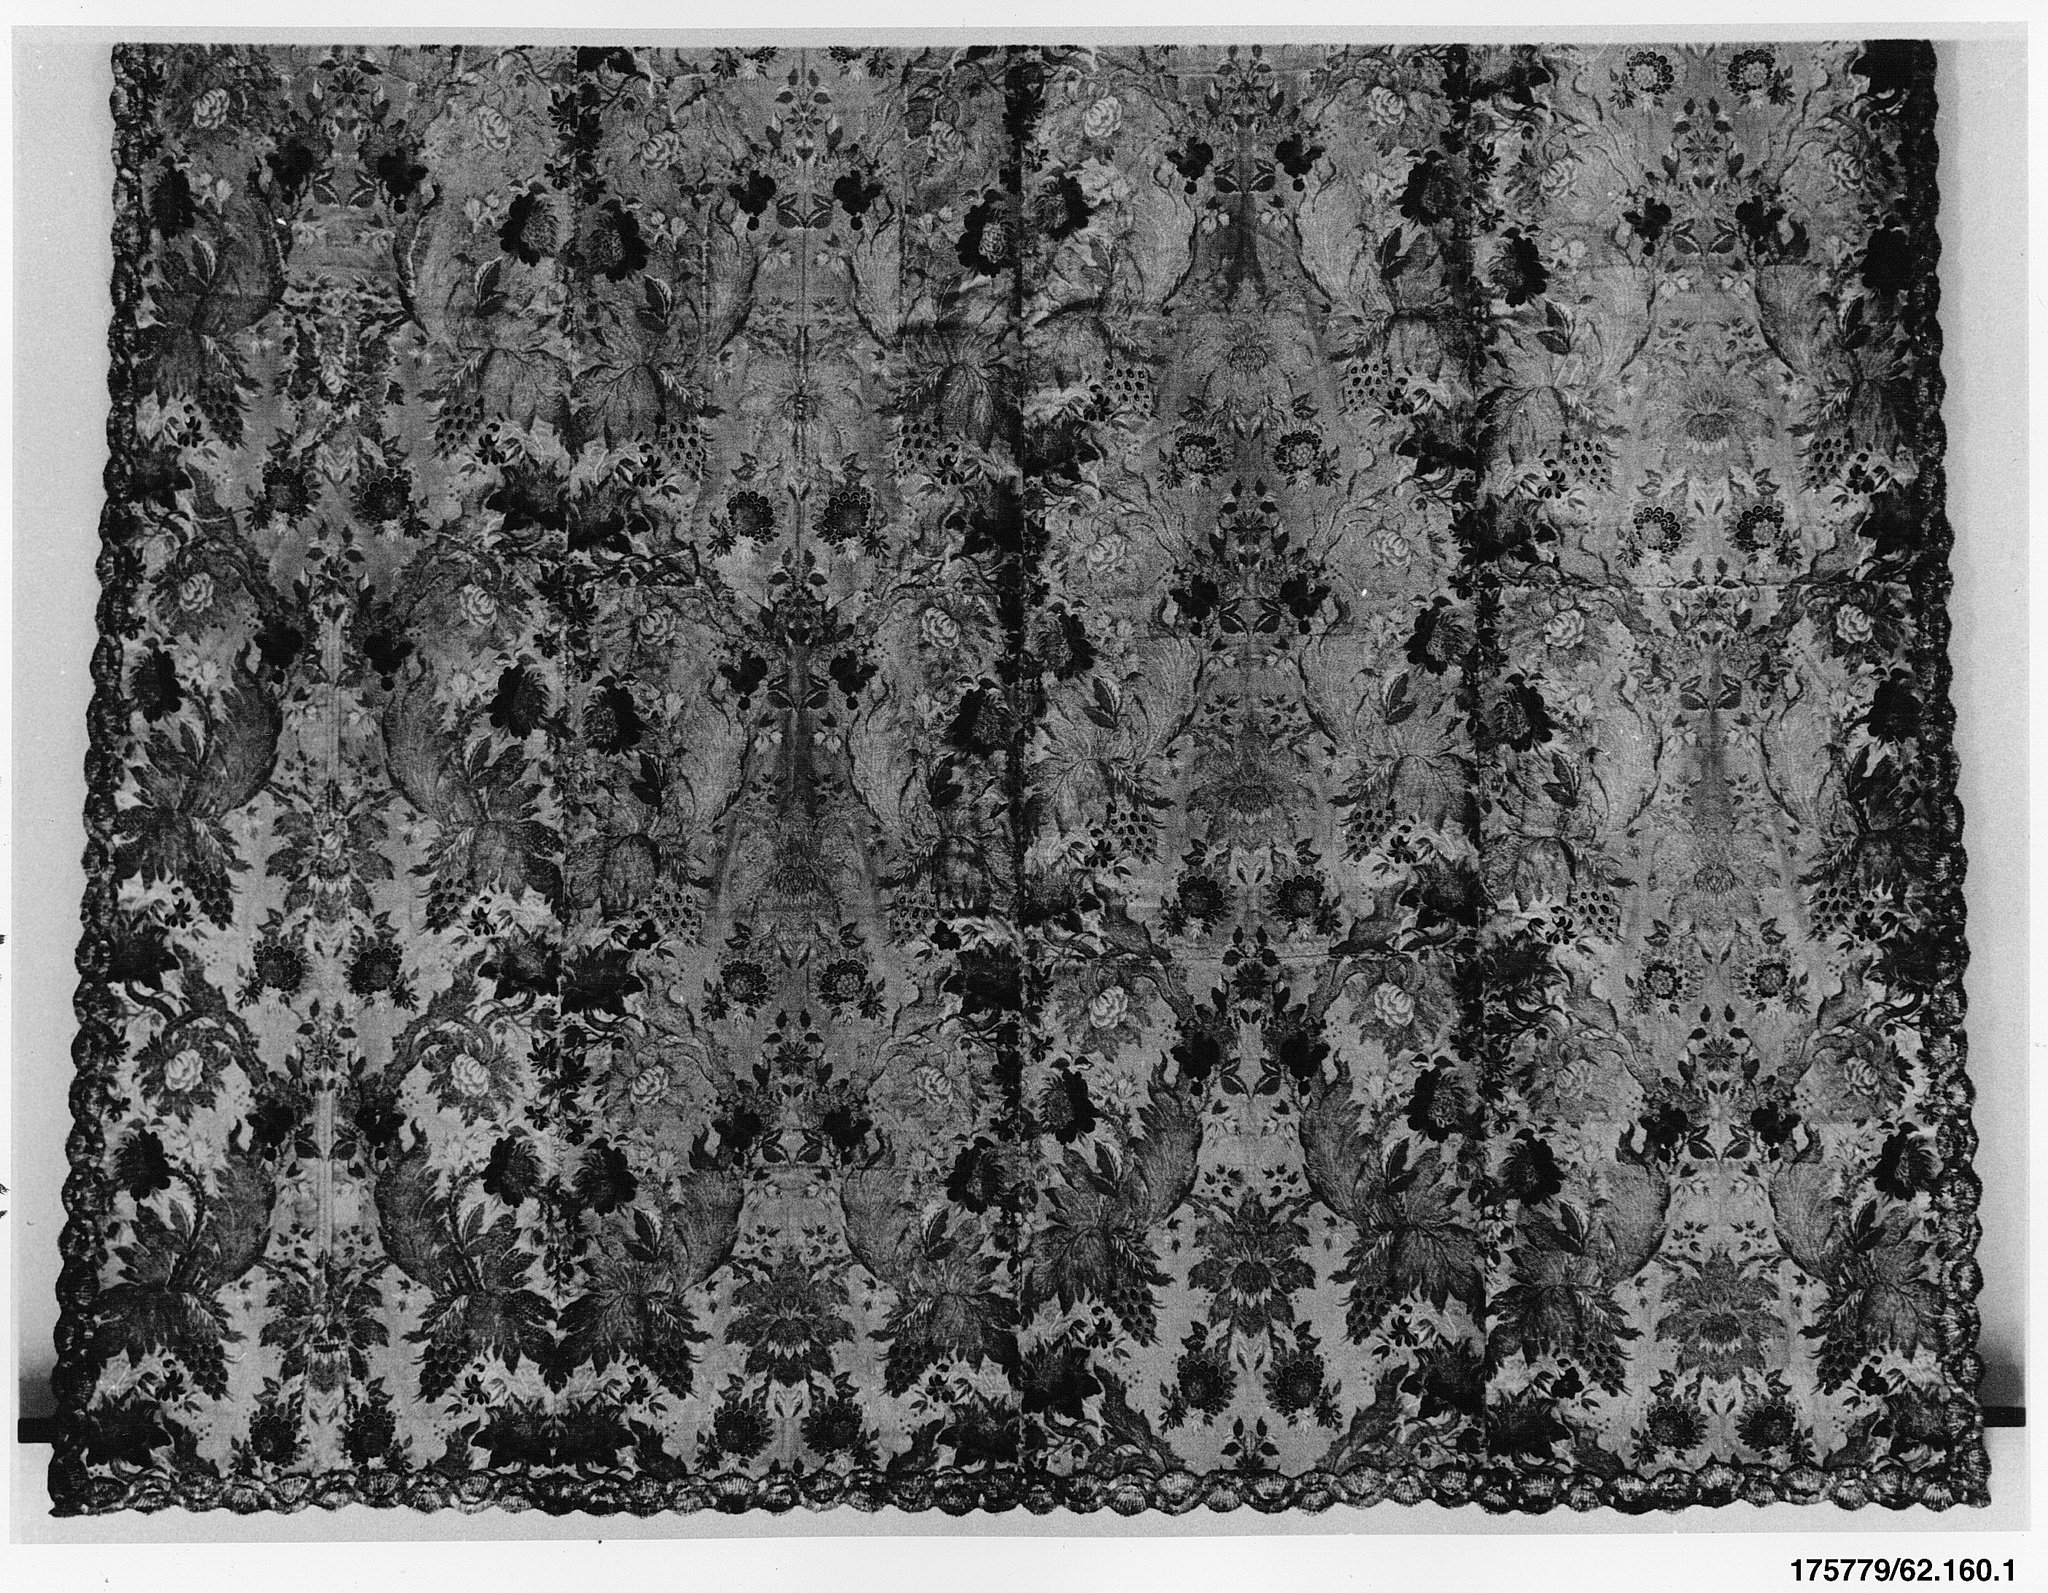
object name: panel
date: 1725-1730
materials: metal thread, silk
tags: flowers,leaves